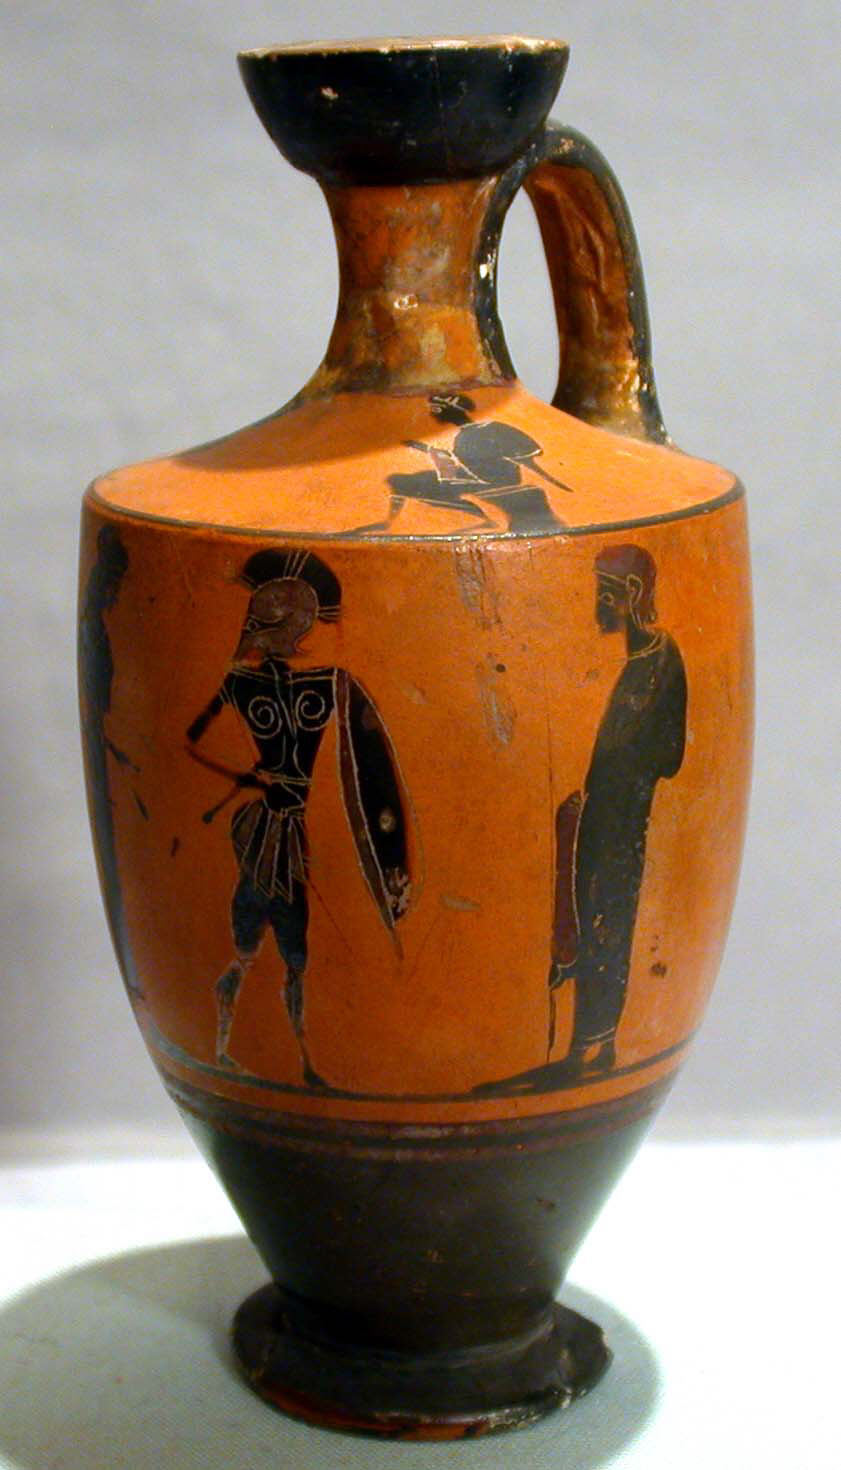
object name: lekythos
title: Terracotta lekythos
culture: greek, attic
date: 534-468 BCE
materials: terracotta